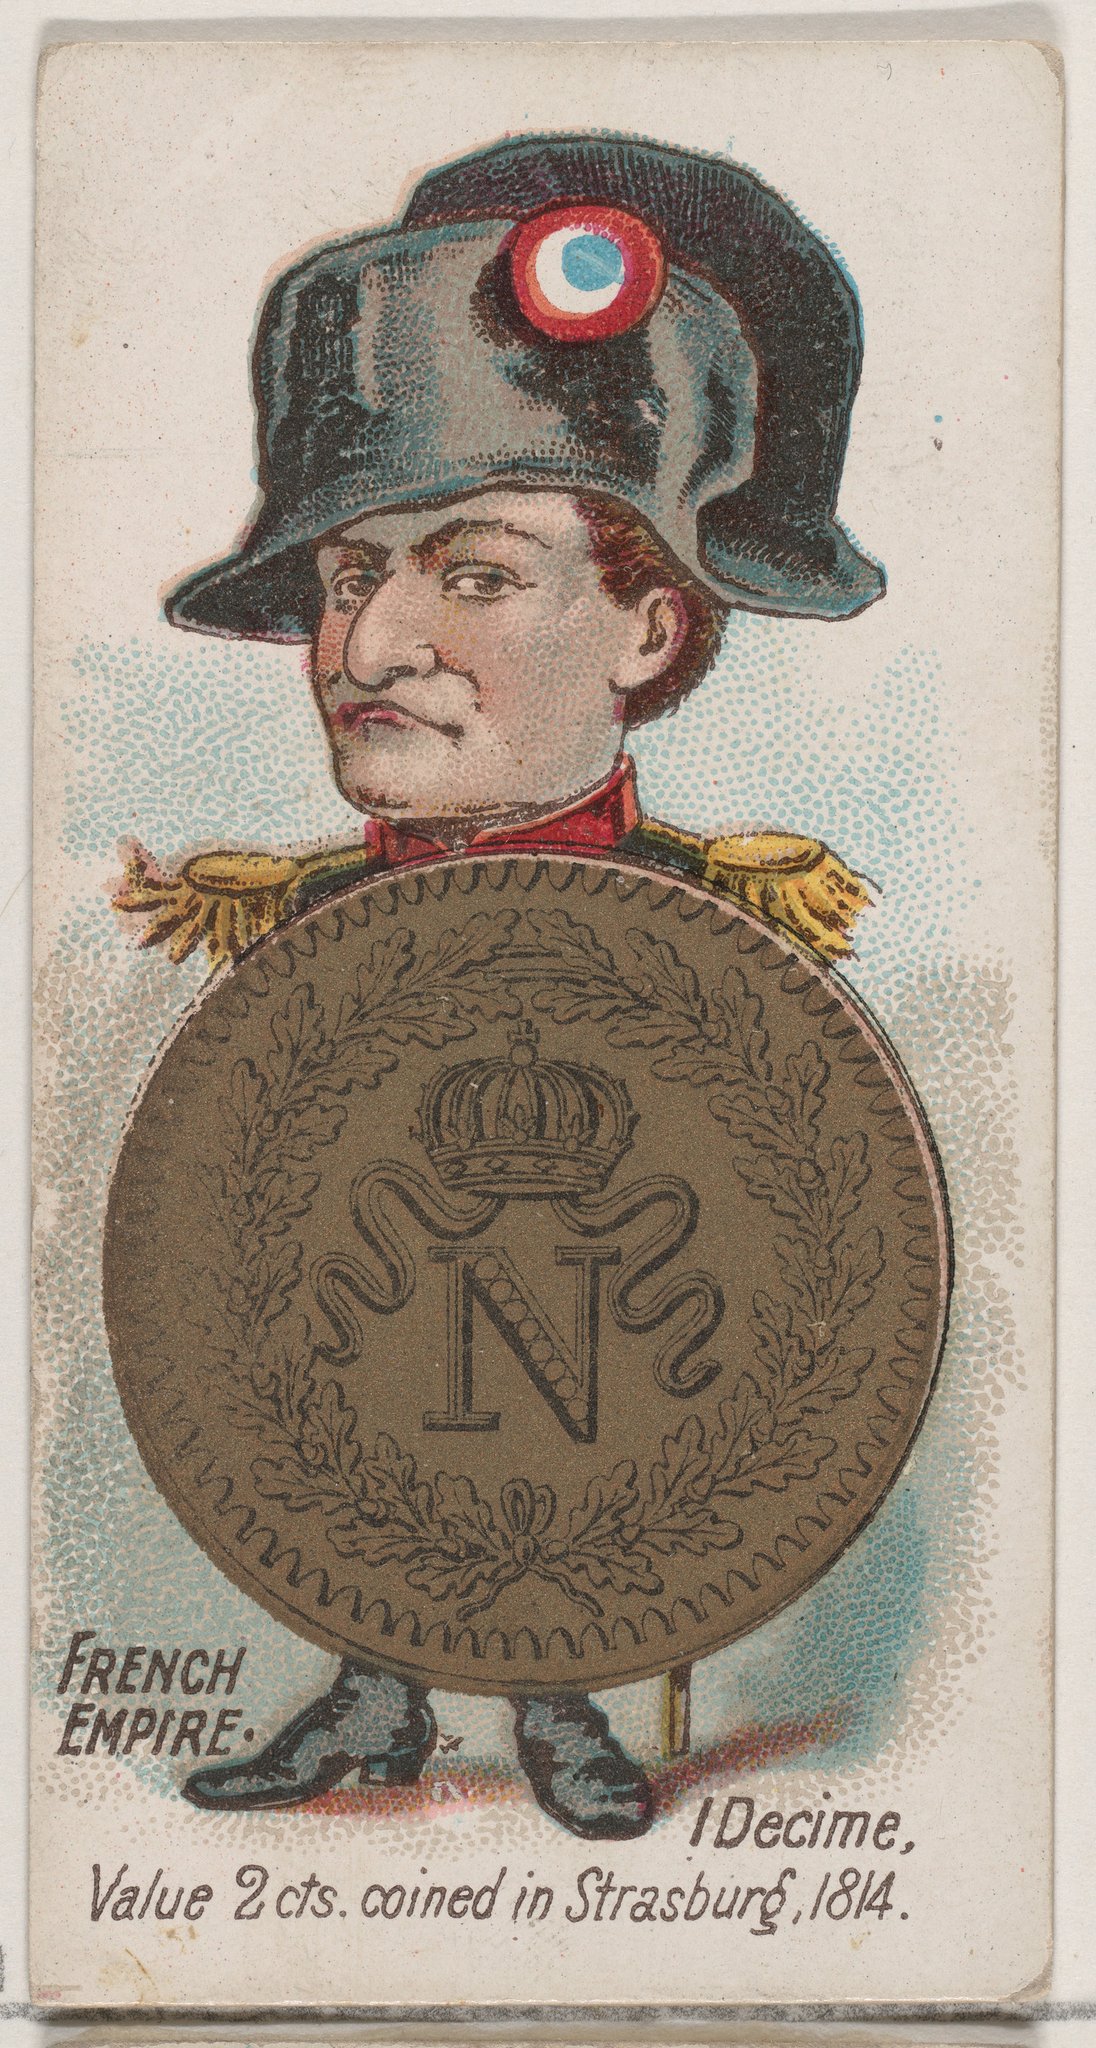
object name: print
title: French Empire, 1 Decime, from the series Coins of All Nations (N72, variation 1) for Duke brand cigarettes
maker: w. duke, sons & co.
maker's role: publisher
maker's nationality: american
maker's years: 1870-1920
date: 1889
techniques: color lithograph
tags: men,coins